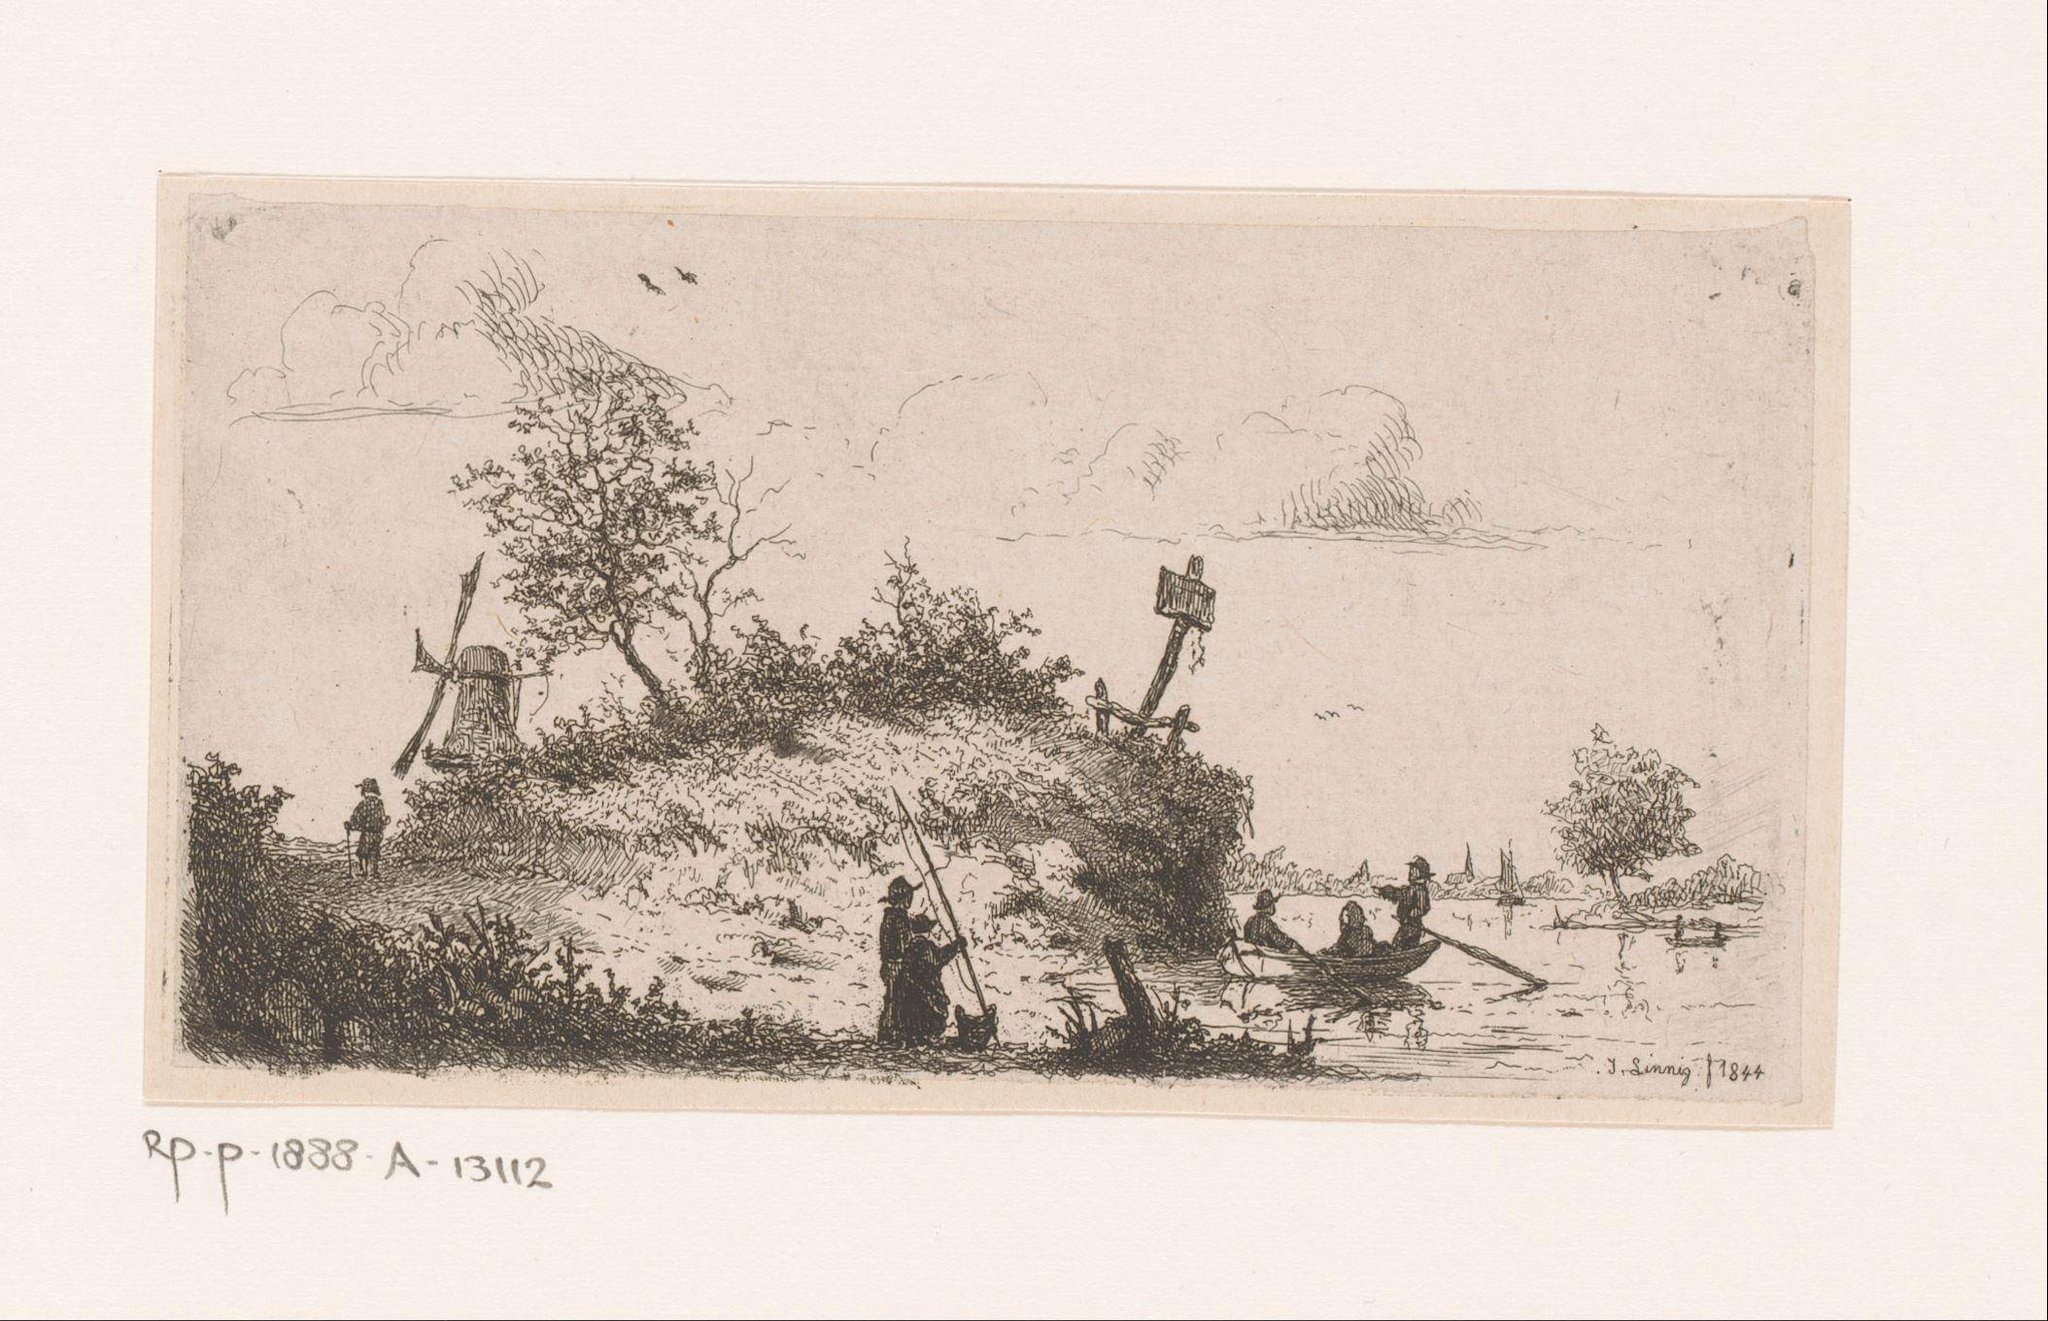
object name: print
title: Gezicht op de Schelde bij Kruibeke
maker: jean théodore joseph linnig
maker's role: draughtsman, print maker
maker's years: 1815-1891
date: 1844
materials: paper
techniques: etching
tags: sailing-ship, sailing-boat, river, windmill in landscape, angling, antwerp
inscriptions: collector's mark: Lugt 2228